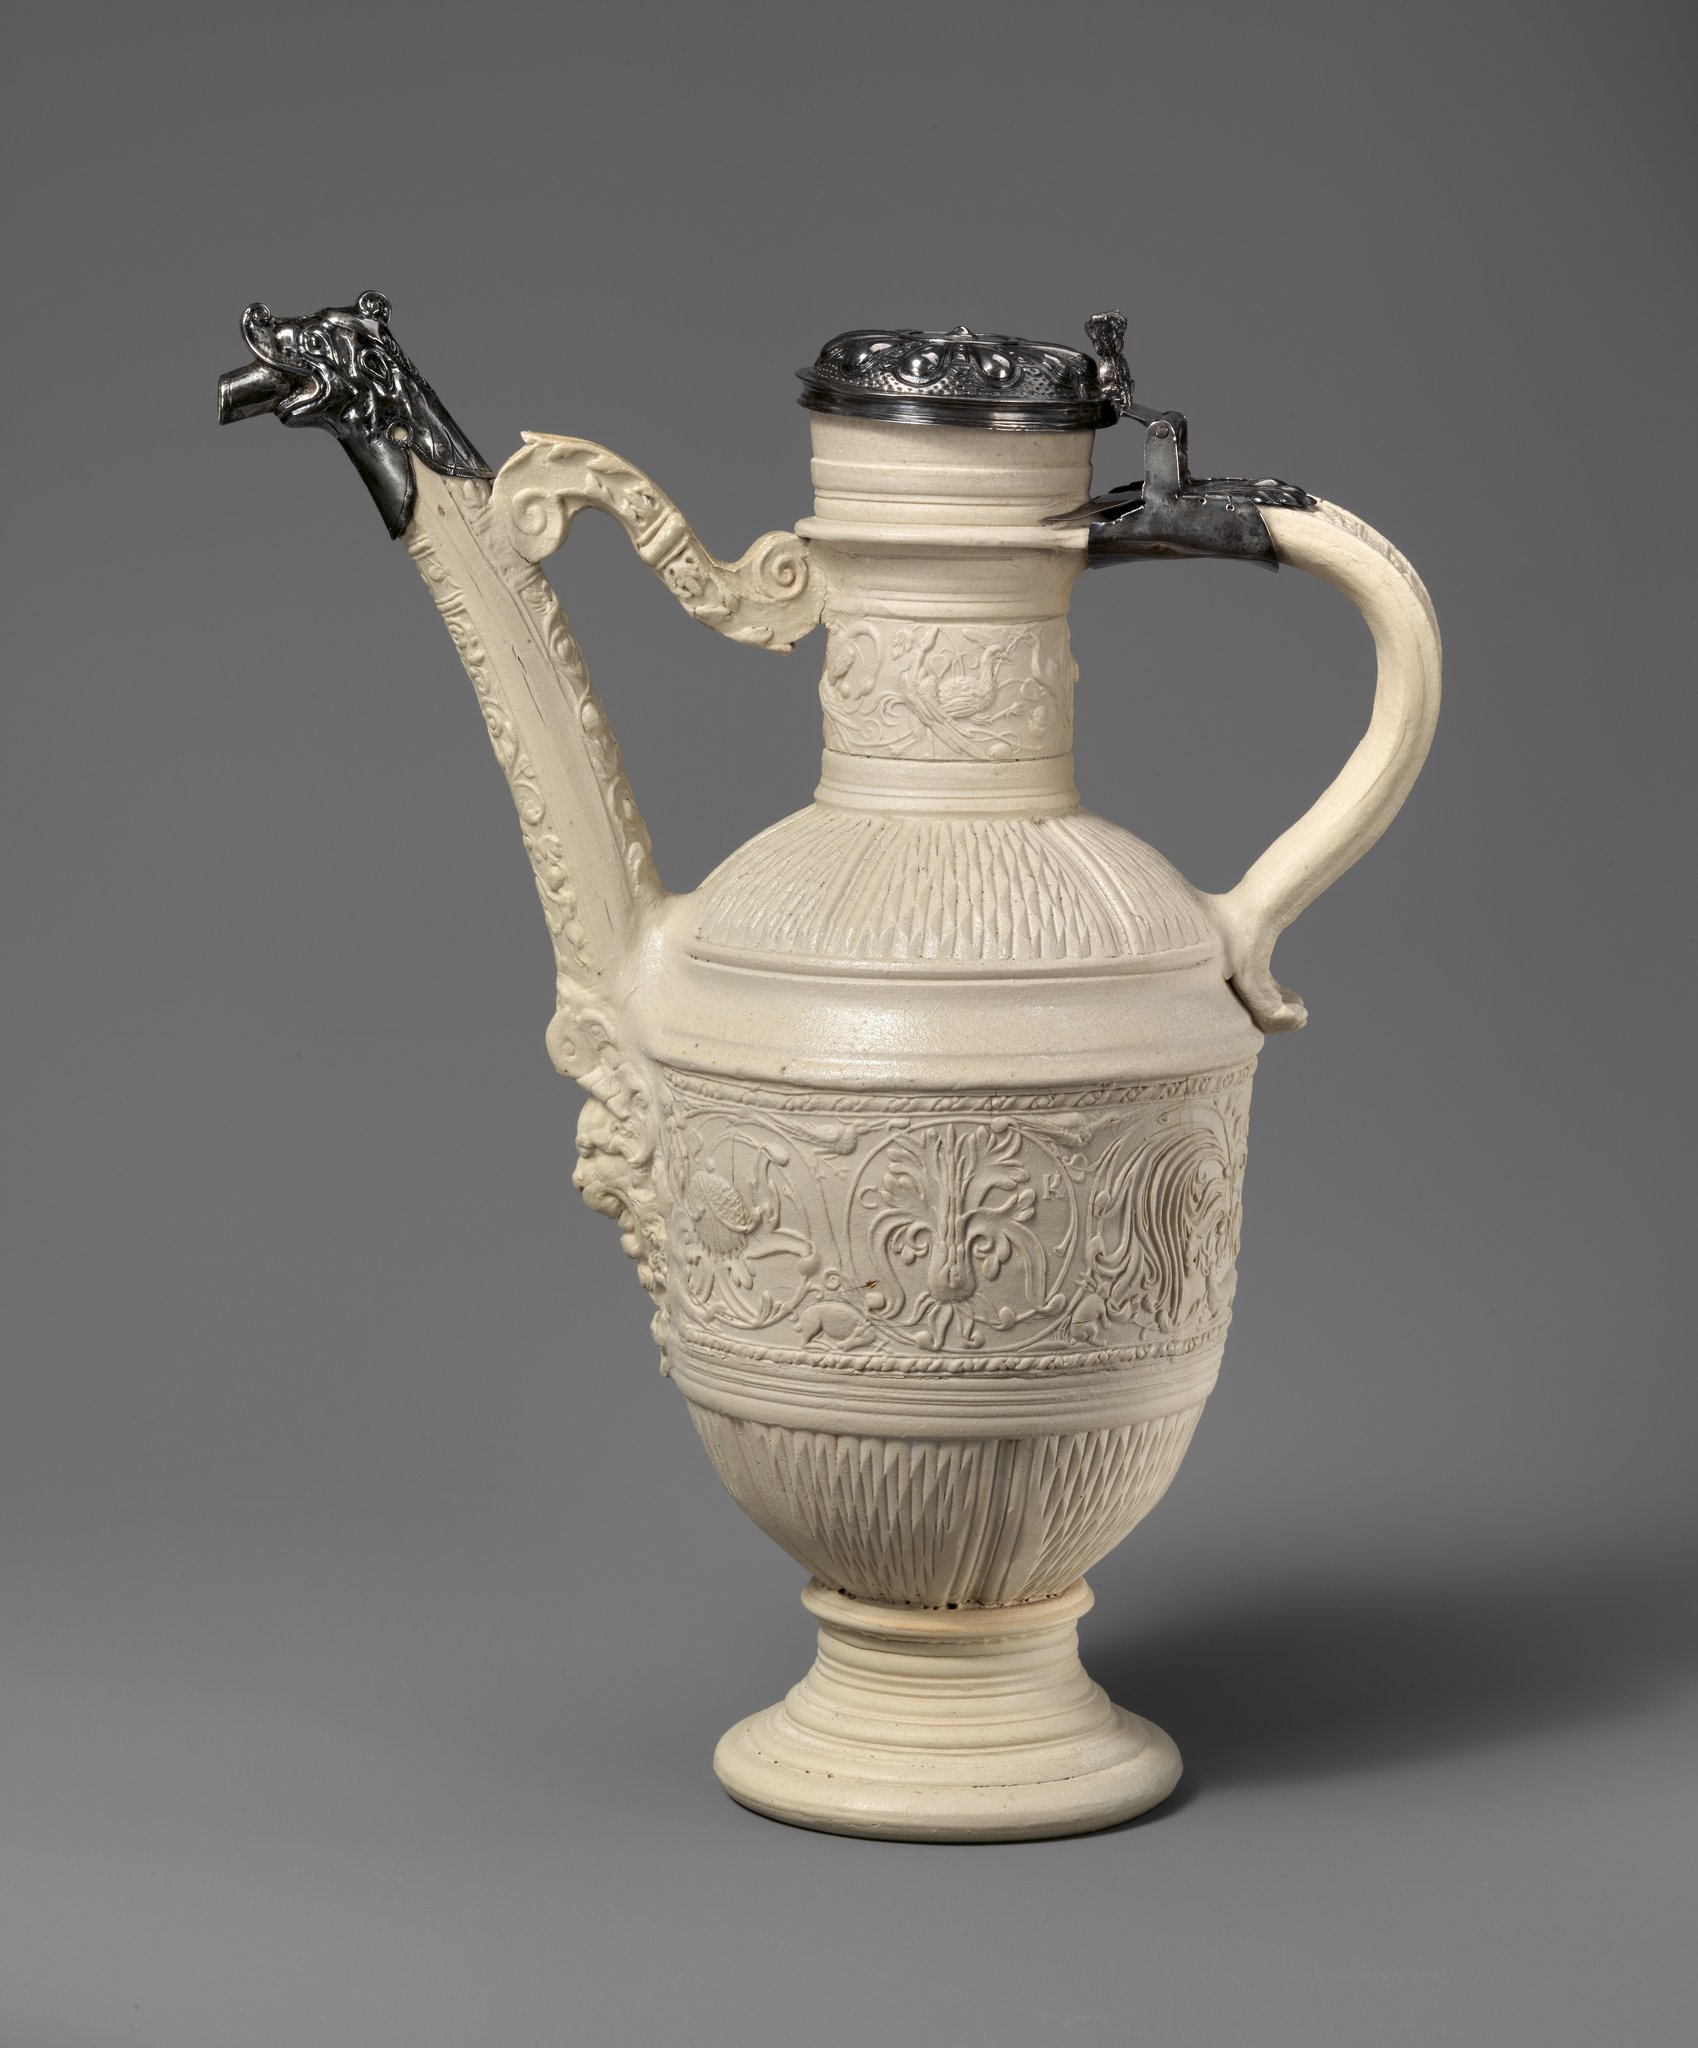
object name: ewer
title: Ewer (Schnabelkanne)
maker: christian knütgen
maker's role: maker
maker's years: 1538-1635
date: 1597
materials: silver, stoneware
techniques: salt glaze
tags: birds